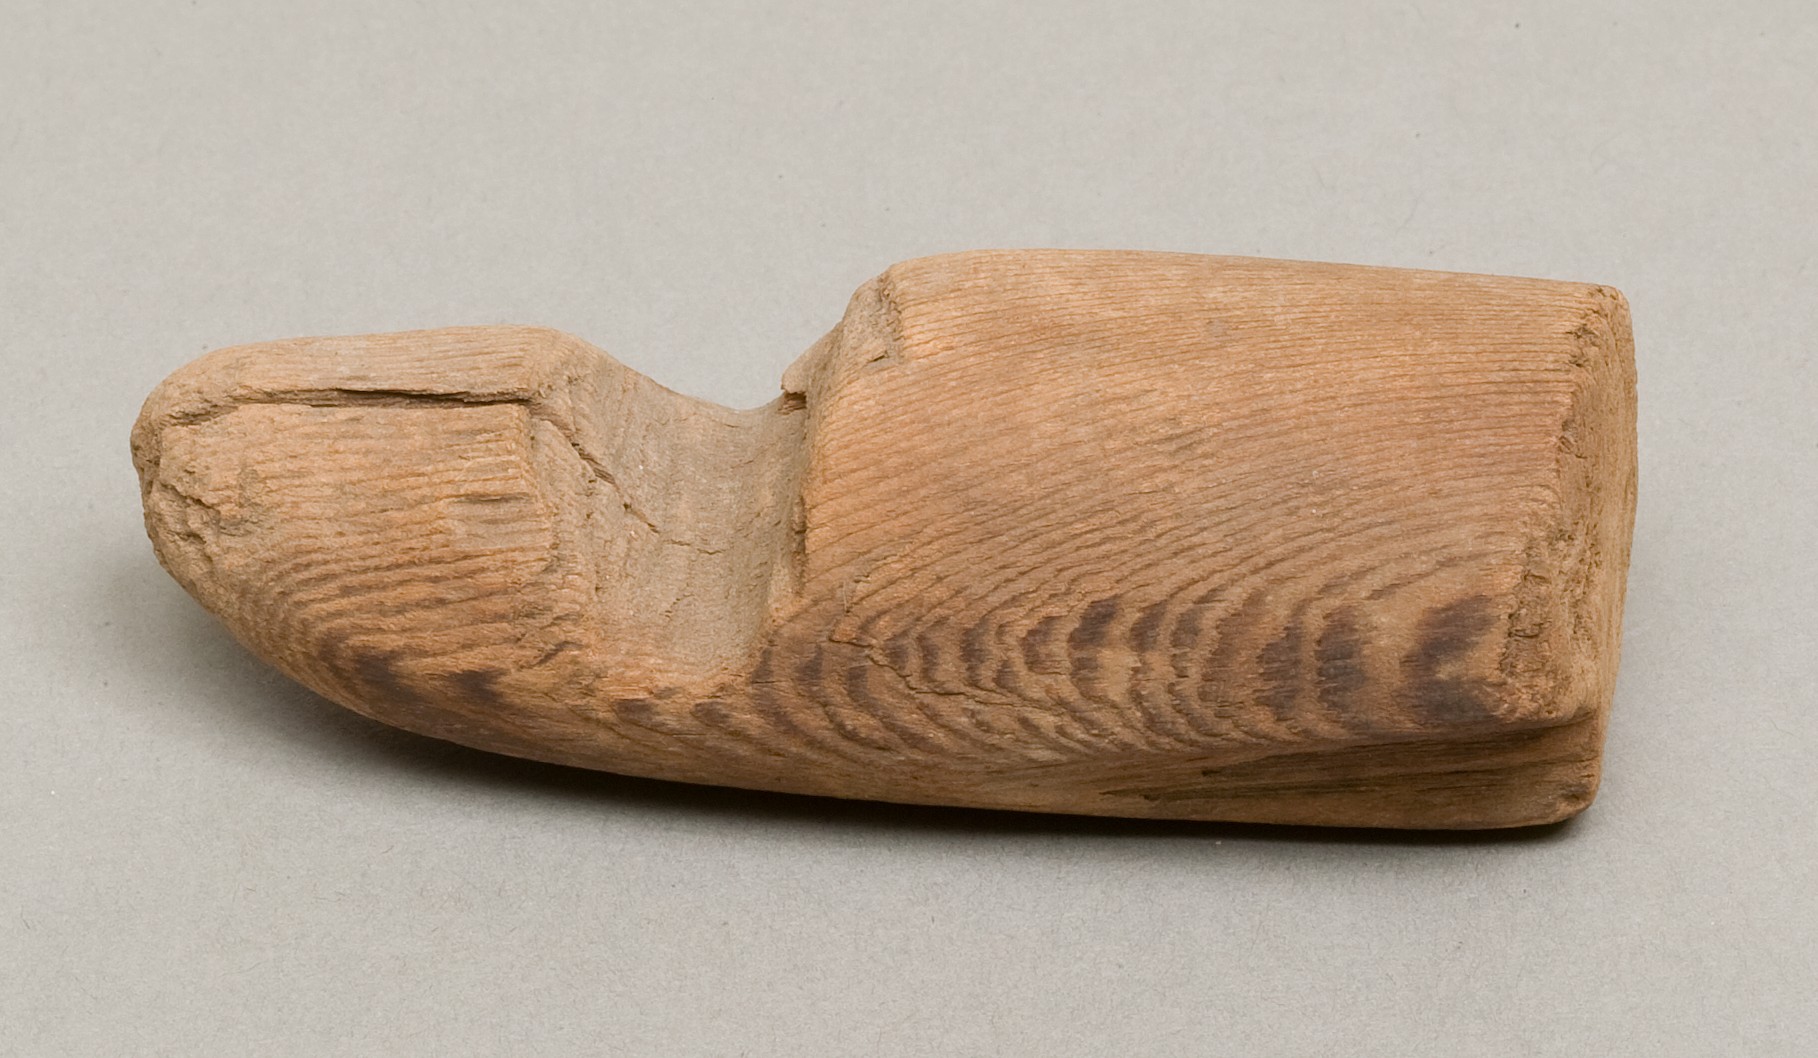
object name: heddle jack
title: Loom Heddle Jack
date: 1850-1070 BCE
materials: wood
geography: egypt